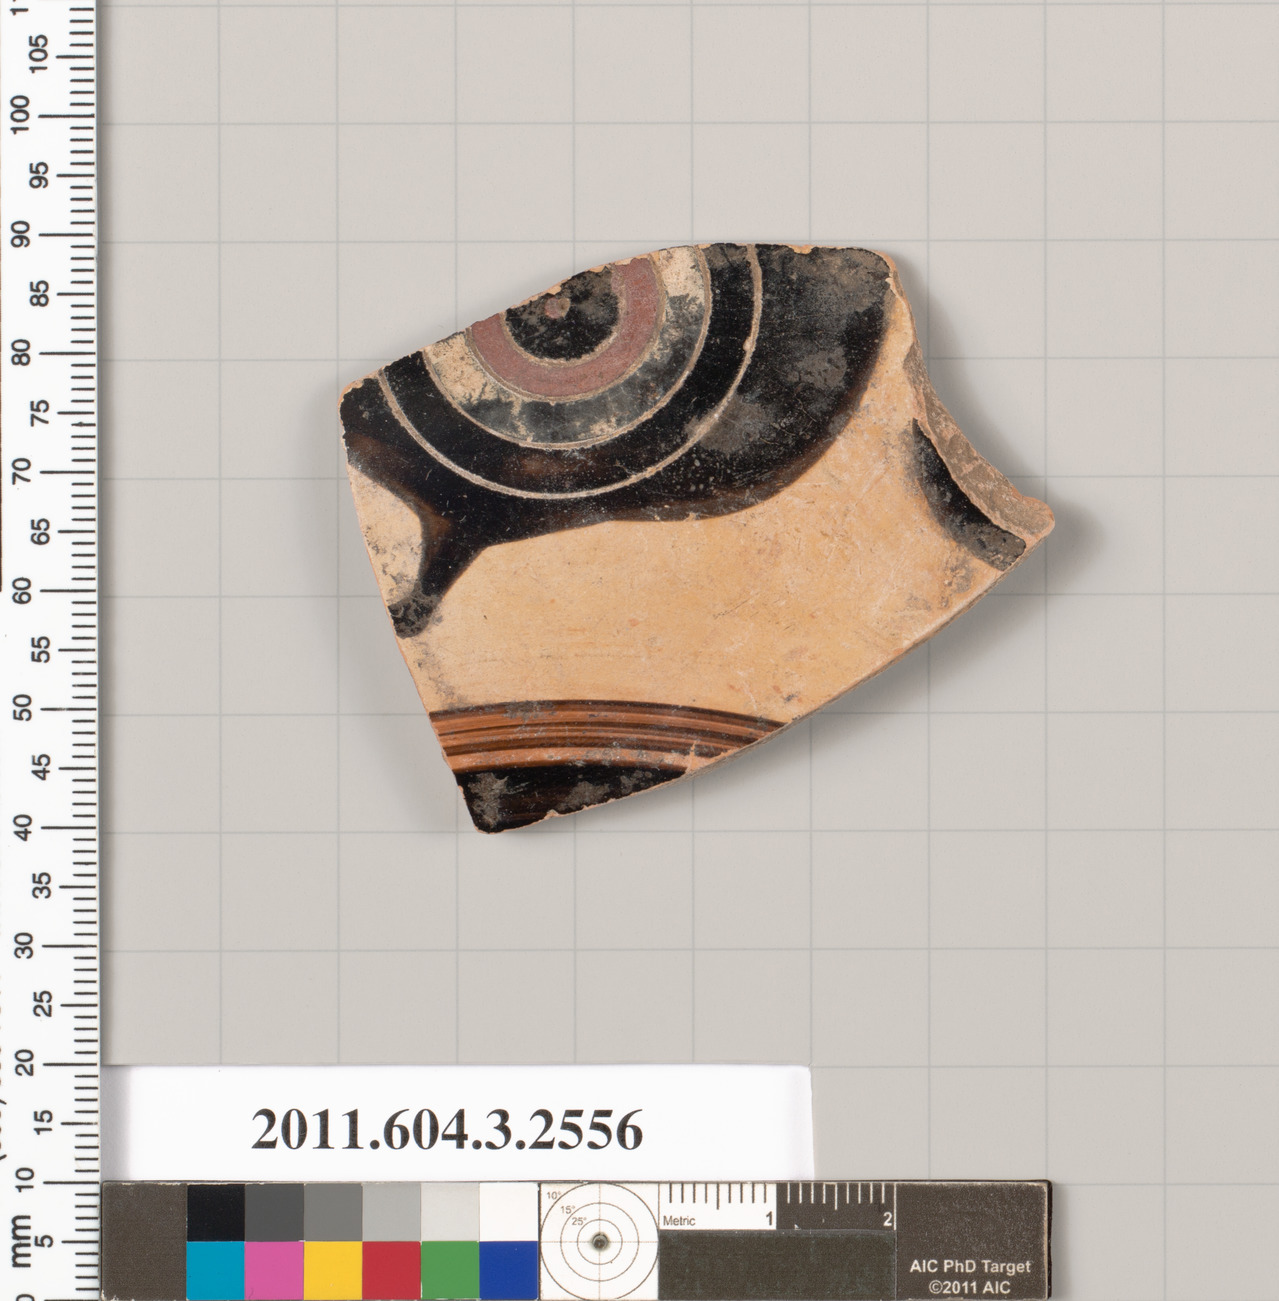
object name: kylix fragment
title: Terracotta fragment of a kylix: eye-cup (drinking cup)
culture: greek, attic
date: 534-468 BCE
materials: terracotta